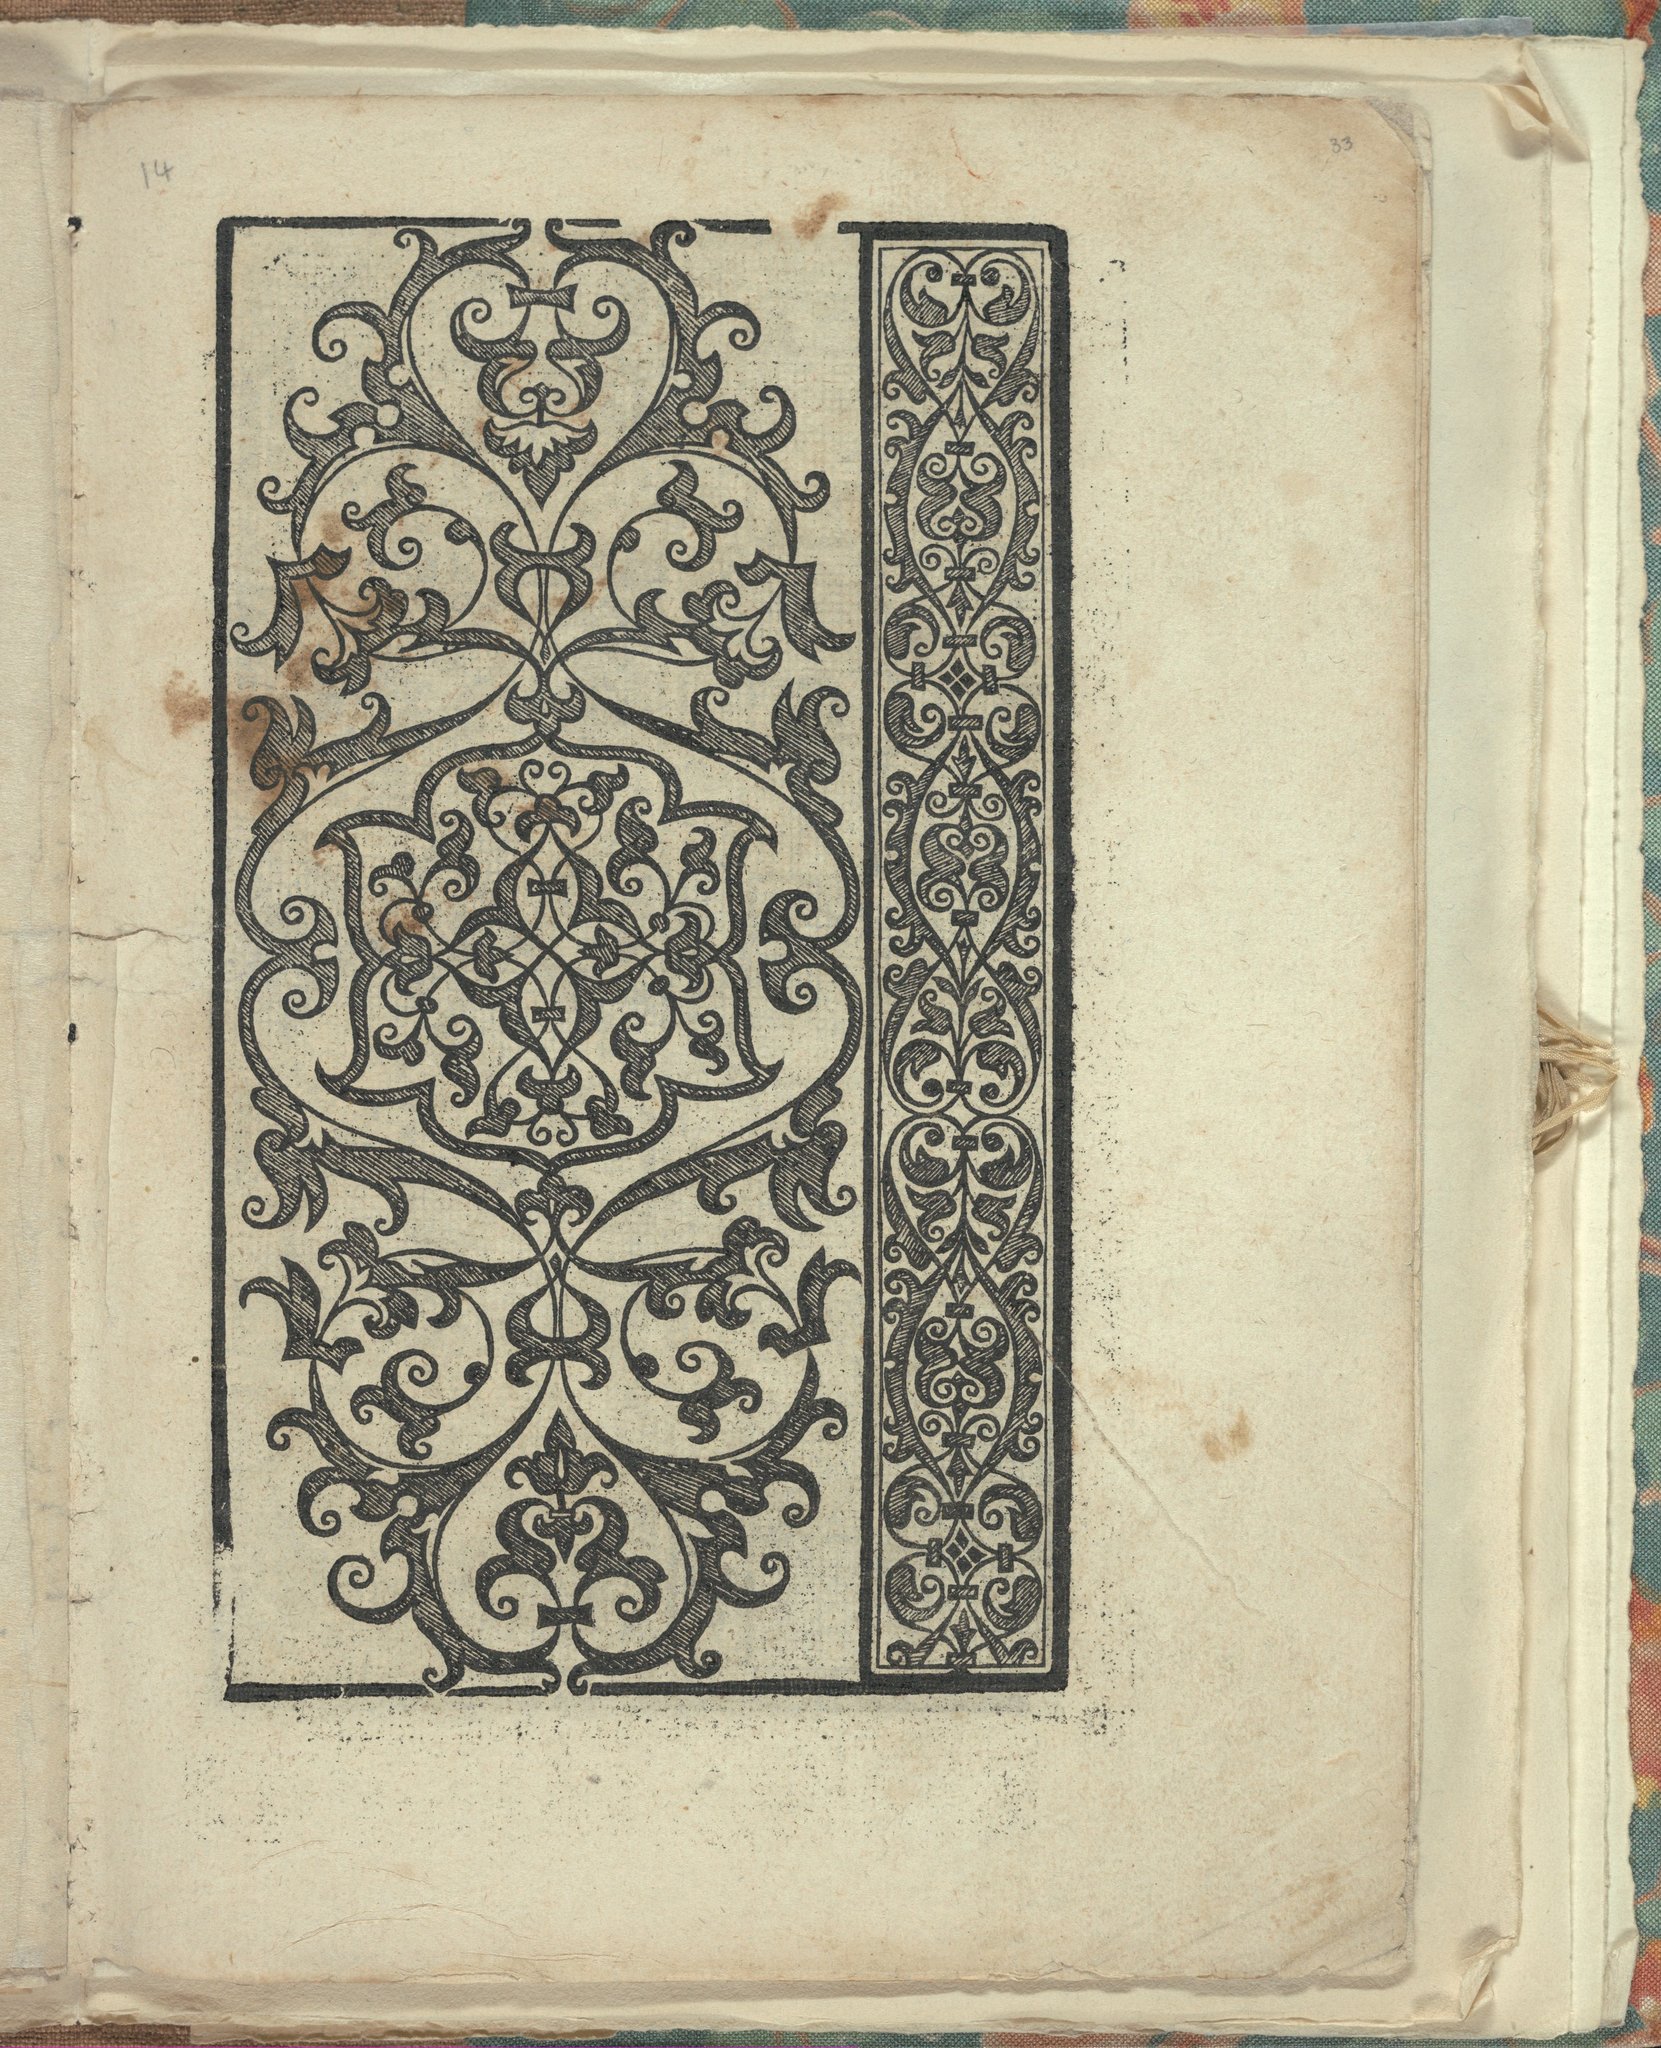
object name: book print ornament architecture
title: Opera Nova Universali intitulata Corona di racammi, page 33 (recto)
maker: giovanni andrea vavassore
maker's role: publisher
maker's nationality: italian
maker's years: 1530-1573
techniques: woodcut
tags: ornament